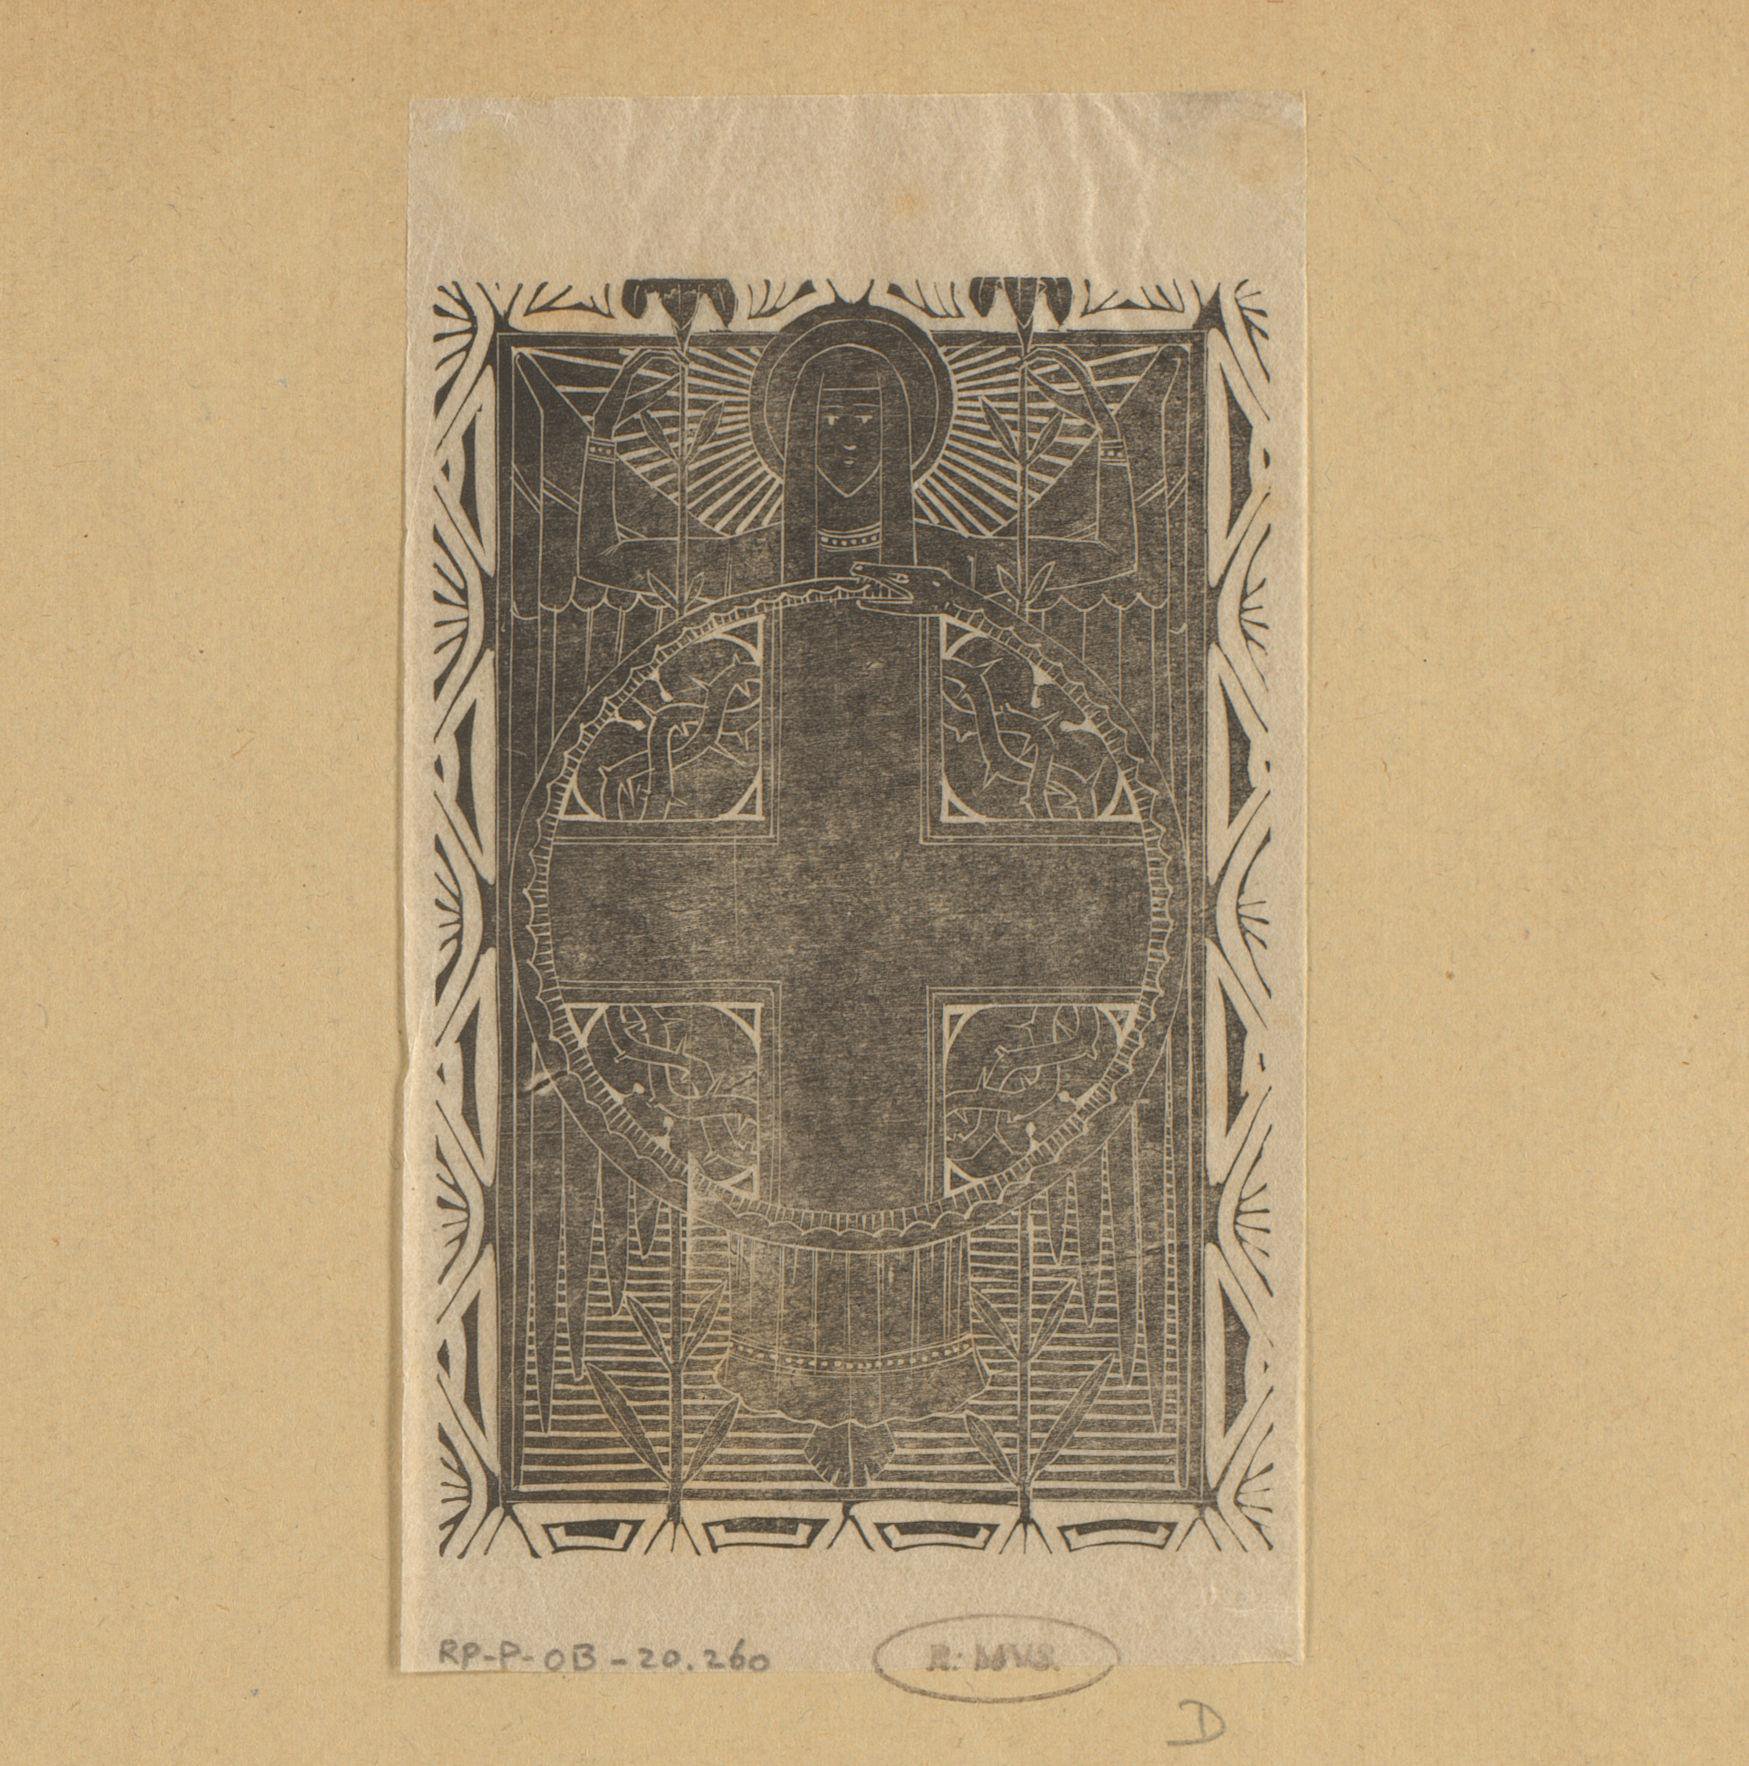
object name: print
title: Kruis met ouroboros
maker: mathieu lauweriks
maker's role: designer, draughtsman, print maker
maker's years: 1864-1932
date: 1874-1932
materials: paper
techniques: woodcut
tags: nimbus, halo ~ radiance emanating from persons or things, the cross ~ symbols of christ, serpent ouroboros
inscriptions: collector's mark: Lugt 2228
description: Een kruis in een cirkel omgeven door takken met doornen en een ouroboros, een slang die in zijn eigen staart bijt. Achter de cirkel een figuur met een nimbus die beide armen omhooghoudt. Deze prent maakt deel uit van een album.